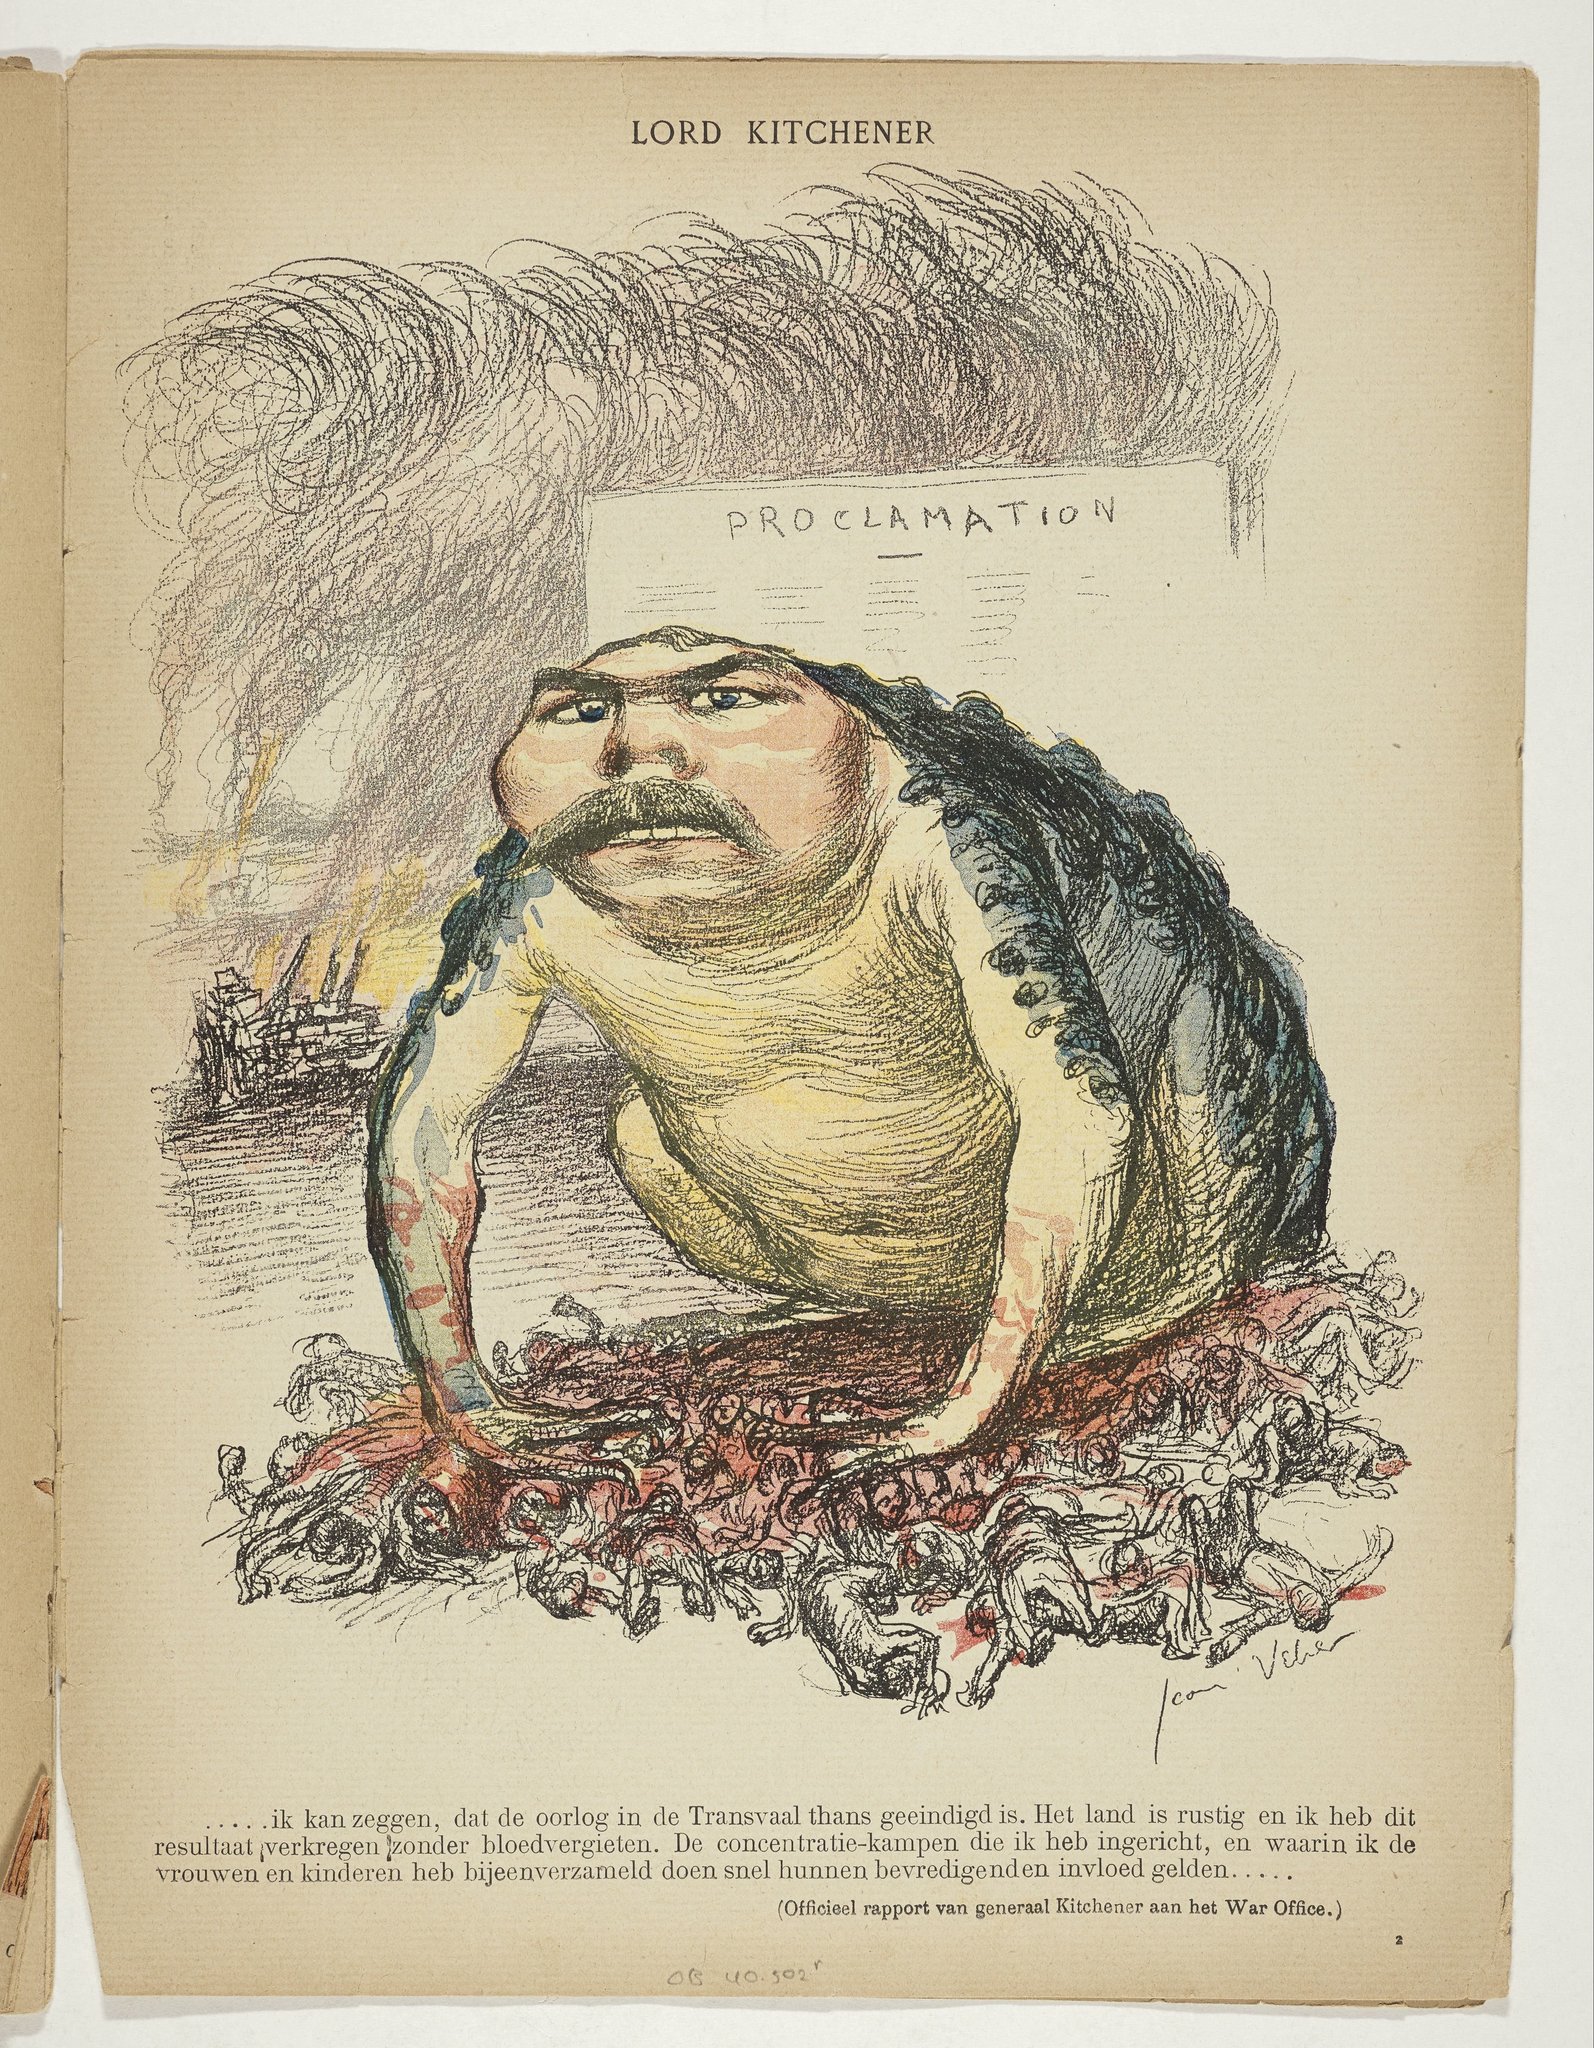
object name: photomechanical print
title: Lord Kitchener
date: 1901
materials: paper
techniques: lithograph, letterpress printing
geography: paris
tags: horatio herbert kitchener, political caricatures and satires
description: Prent maakt deel uit van een tijdschrift met spotprenten op de Tweede Boerenoorlog. Met vierregelig onderschrift: ..... ik kan zeggen, dat de oorlog in de Transvaal thans geeindigd is. Het land is rustig en ik heb dit resultaat verkregen zonder bloedvergieten ... (Officieel rapport van generaal Kitchener aan het War Office.).